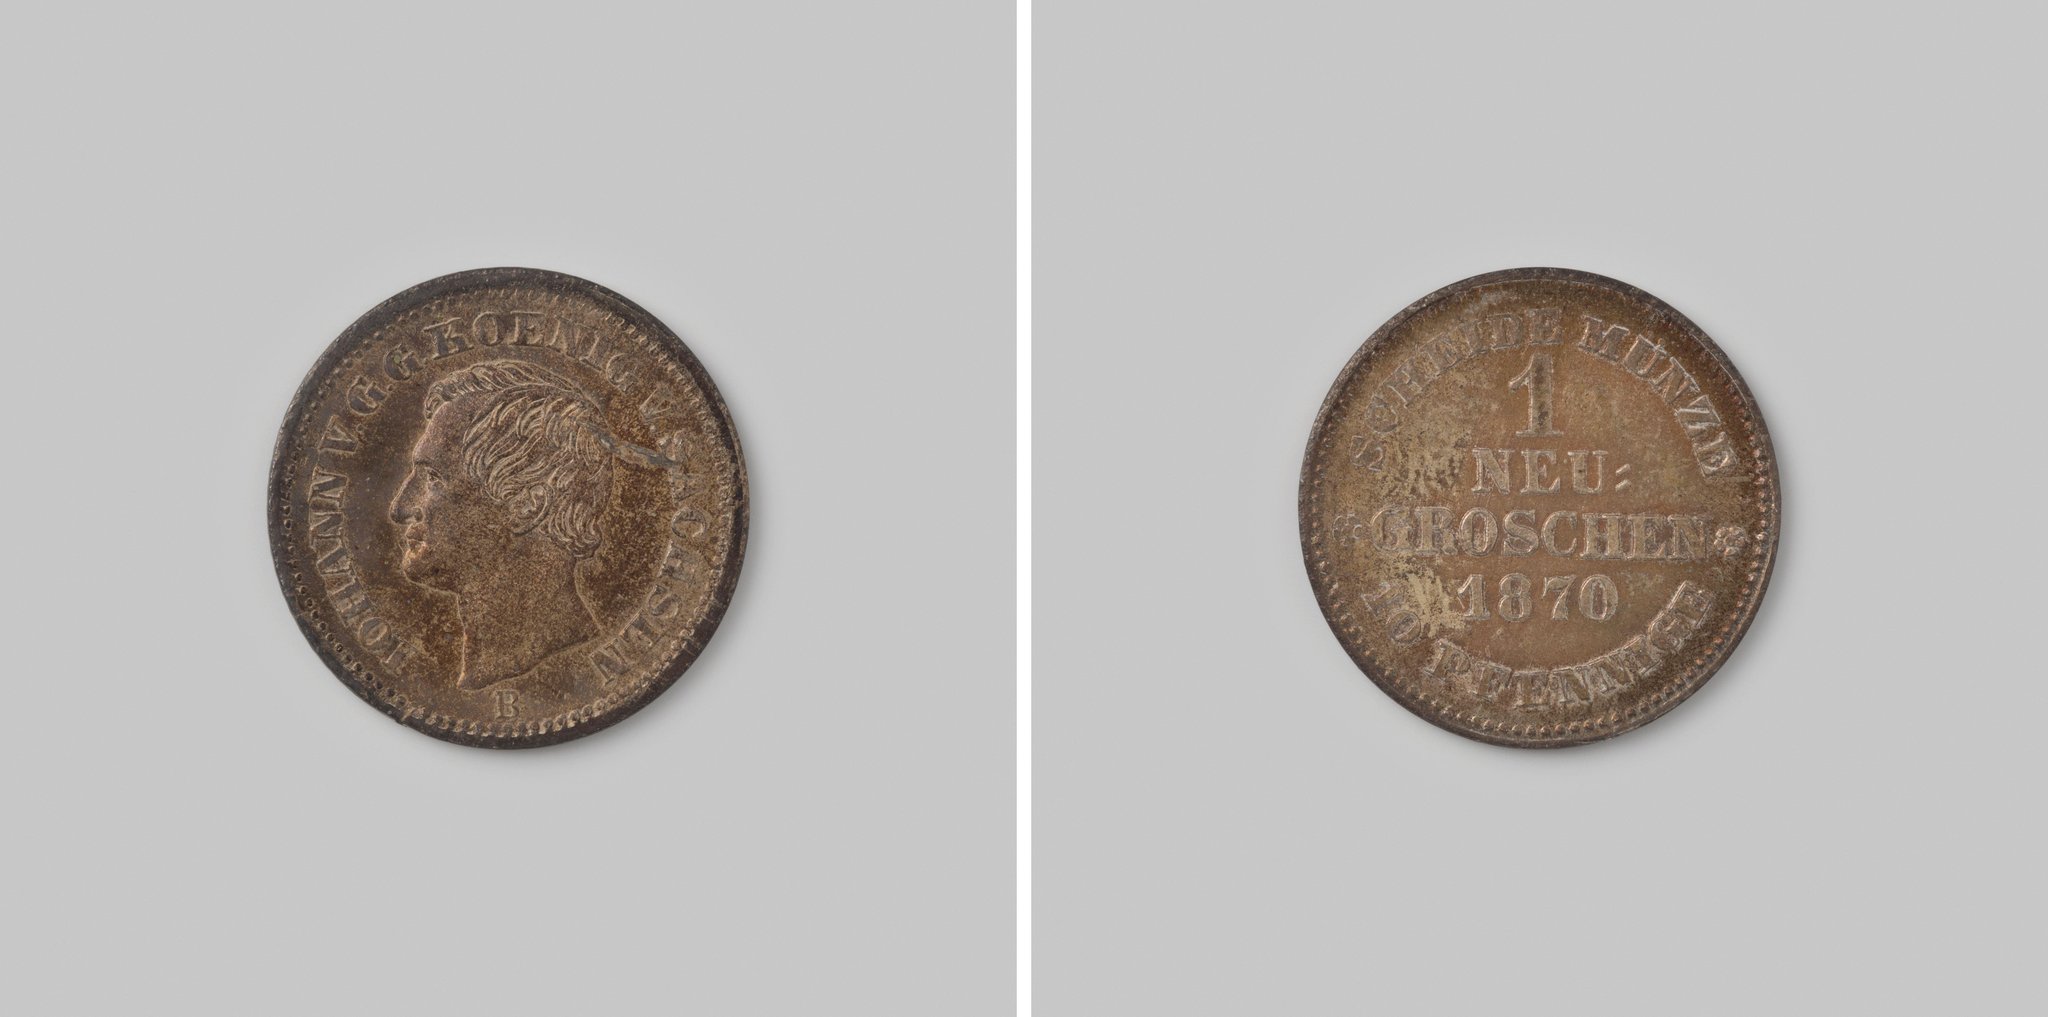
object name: coin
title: Koninkrijk Saksen, Johann, neugroschen,1870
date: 1870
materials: silver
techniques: striking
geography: dresden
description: Zilveren munt. Voorzijde: hoofd van de koning naar links. Onder hoofd letter B. Keerzijde: waarde-aanduiding in drie regels, waaronder jaartal. Kartelrand.